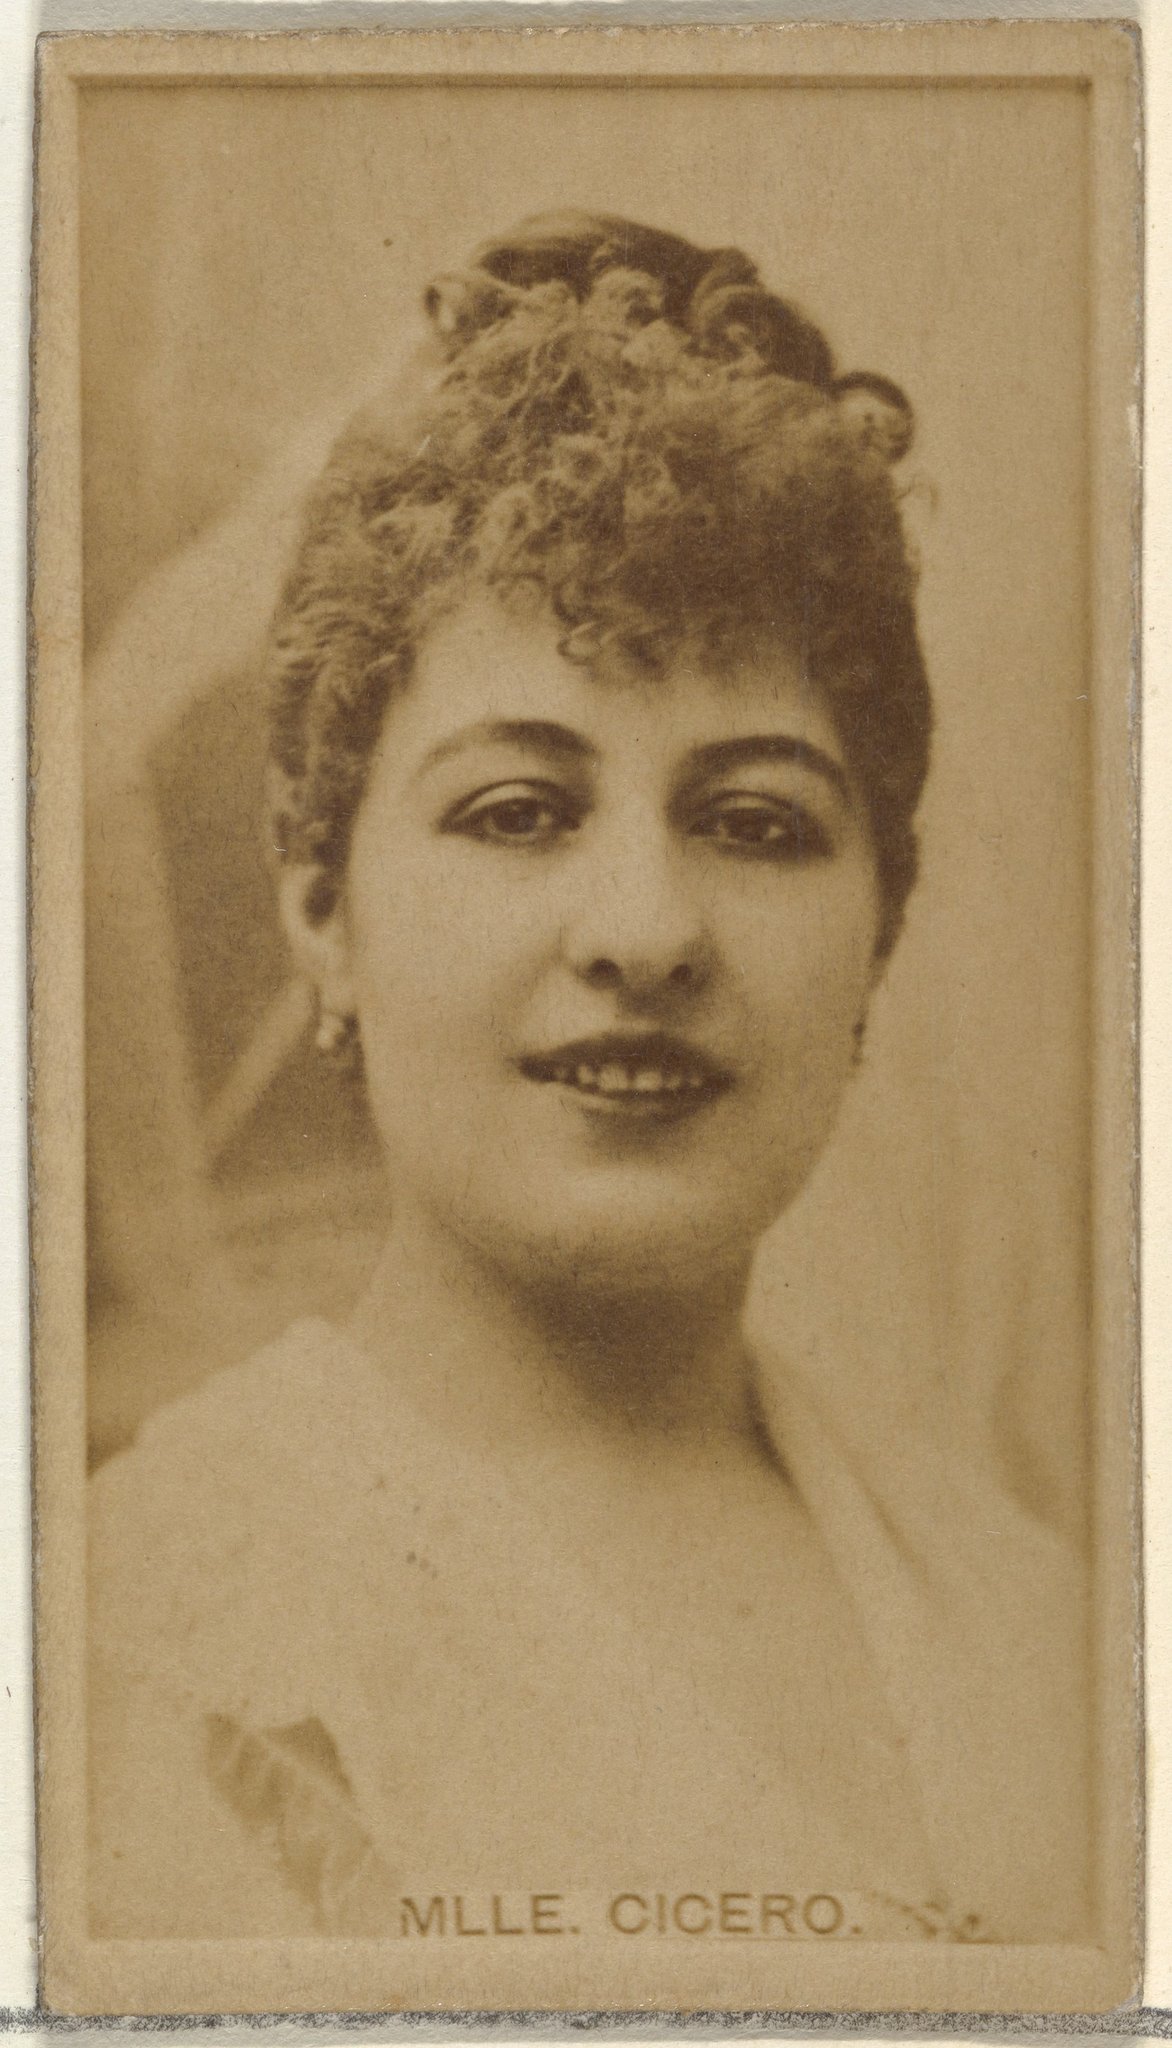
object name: photograph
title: Mlle. Cicero, from the Actors and Actresses series (N145-8) issued by Duke Sons & Co. to promote Duke Cigarettes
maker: w. duke, sons & co.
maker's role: publisher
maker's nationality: american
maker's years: 1870-1920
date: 1891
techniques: albumen silver print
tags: portraits,women,actresses